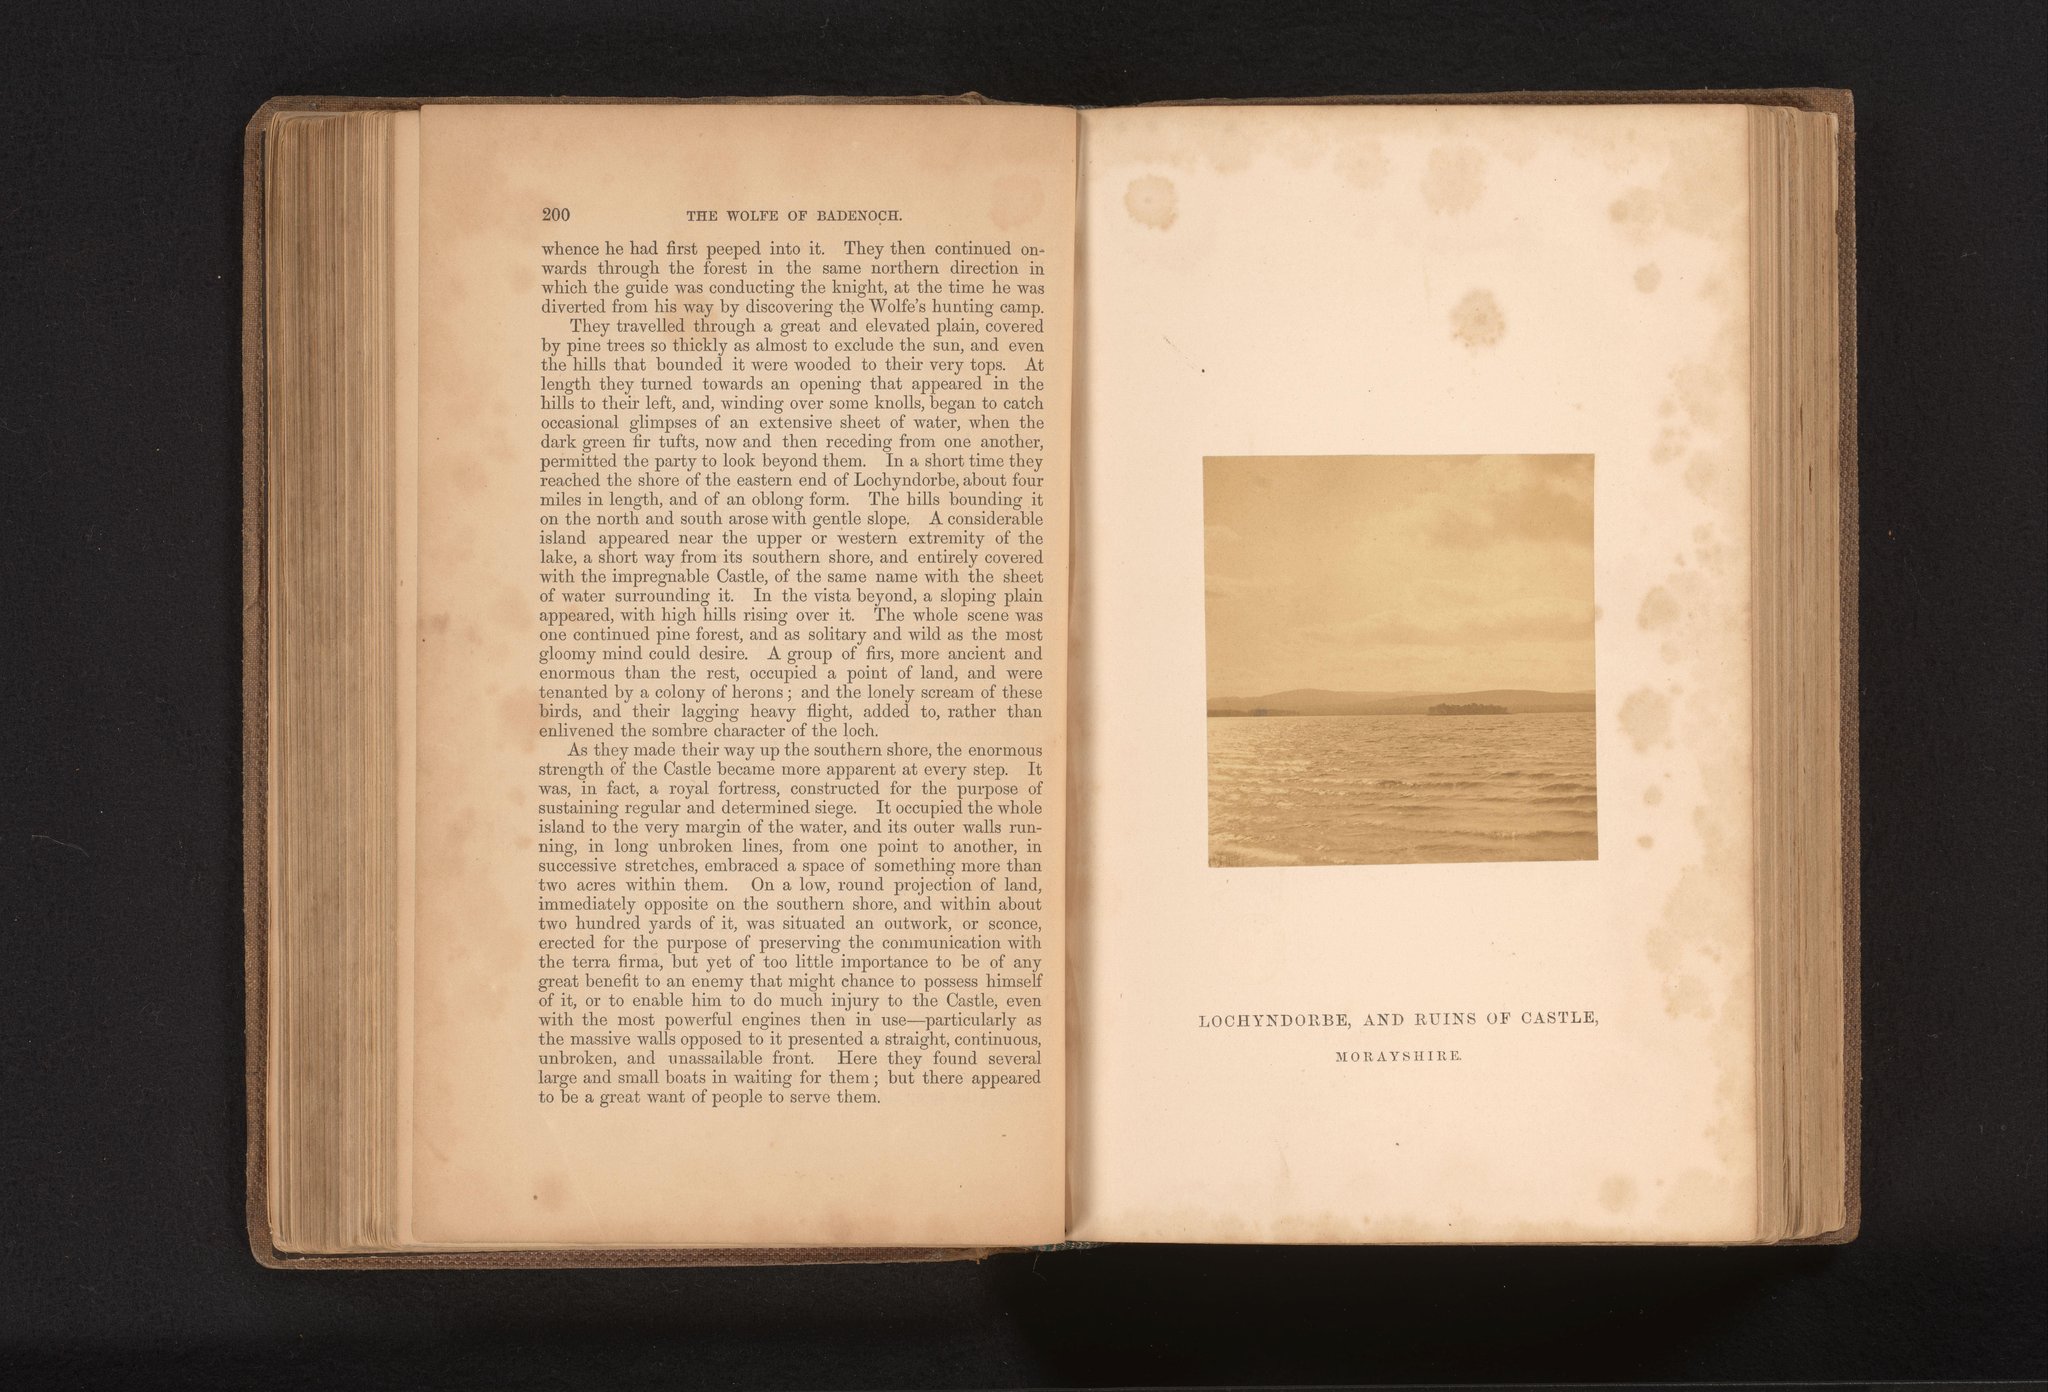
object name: page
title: Lochyndorbe, and Ruins of Castle, Morayshire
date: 1858-1863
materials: photographic support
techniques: albumen print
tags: lake